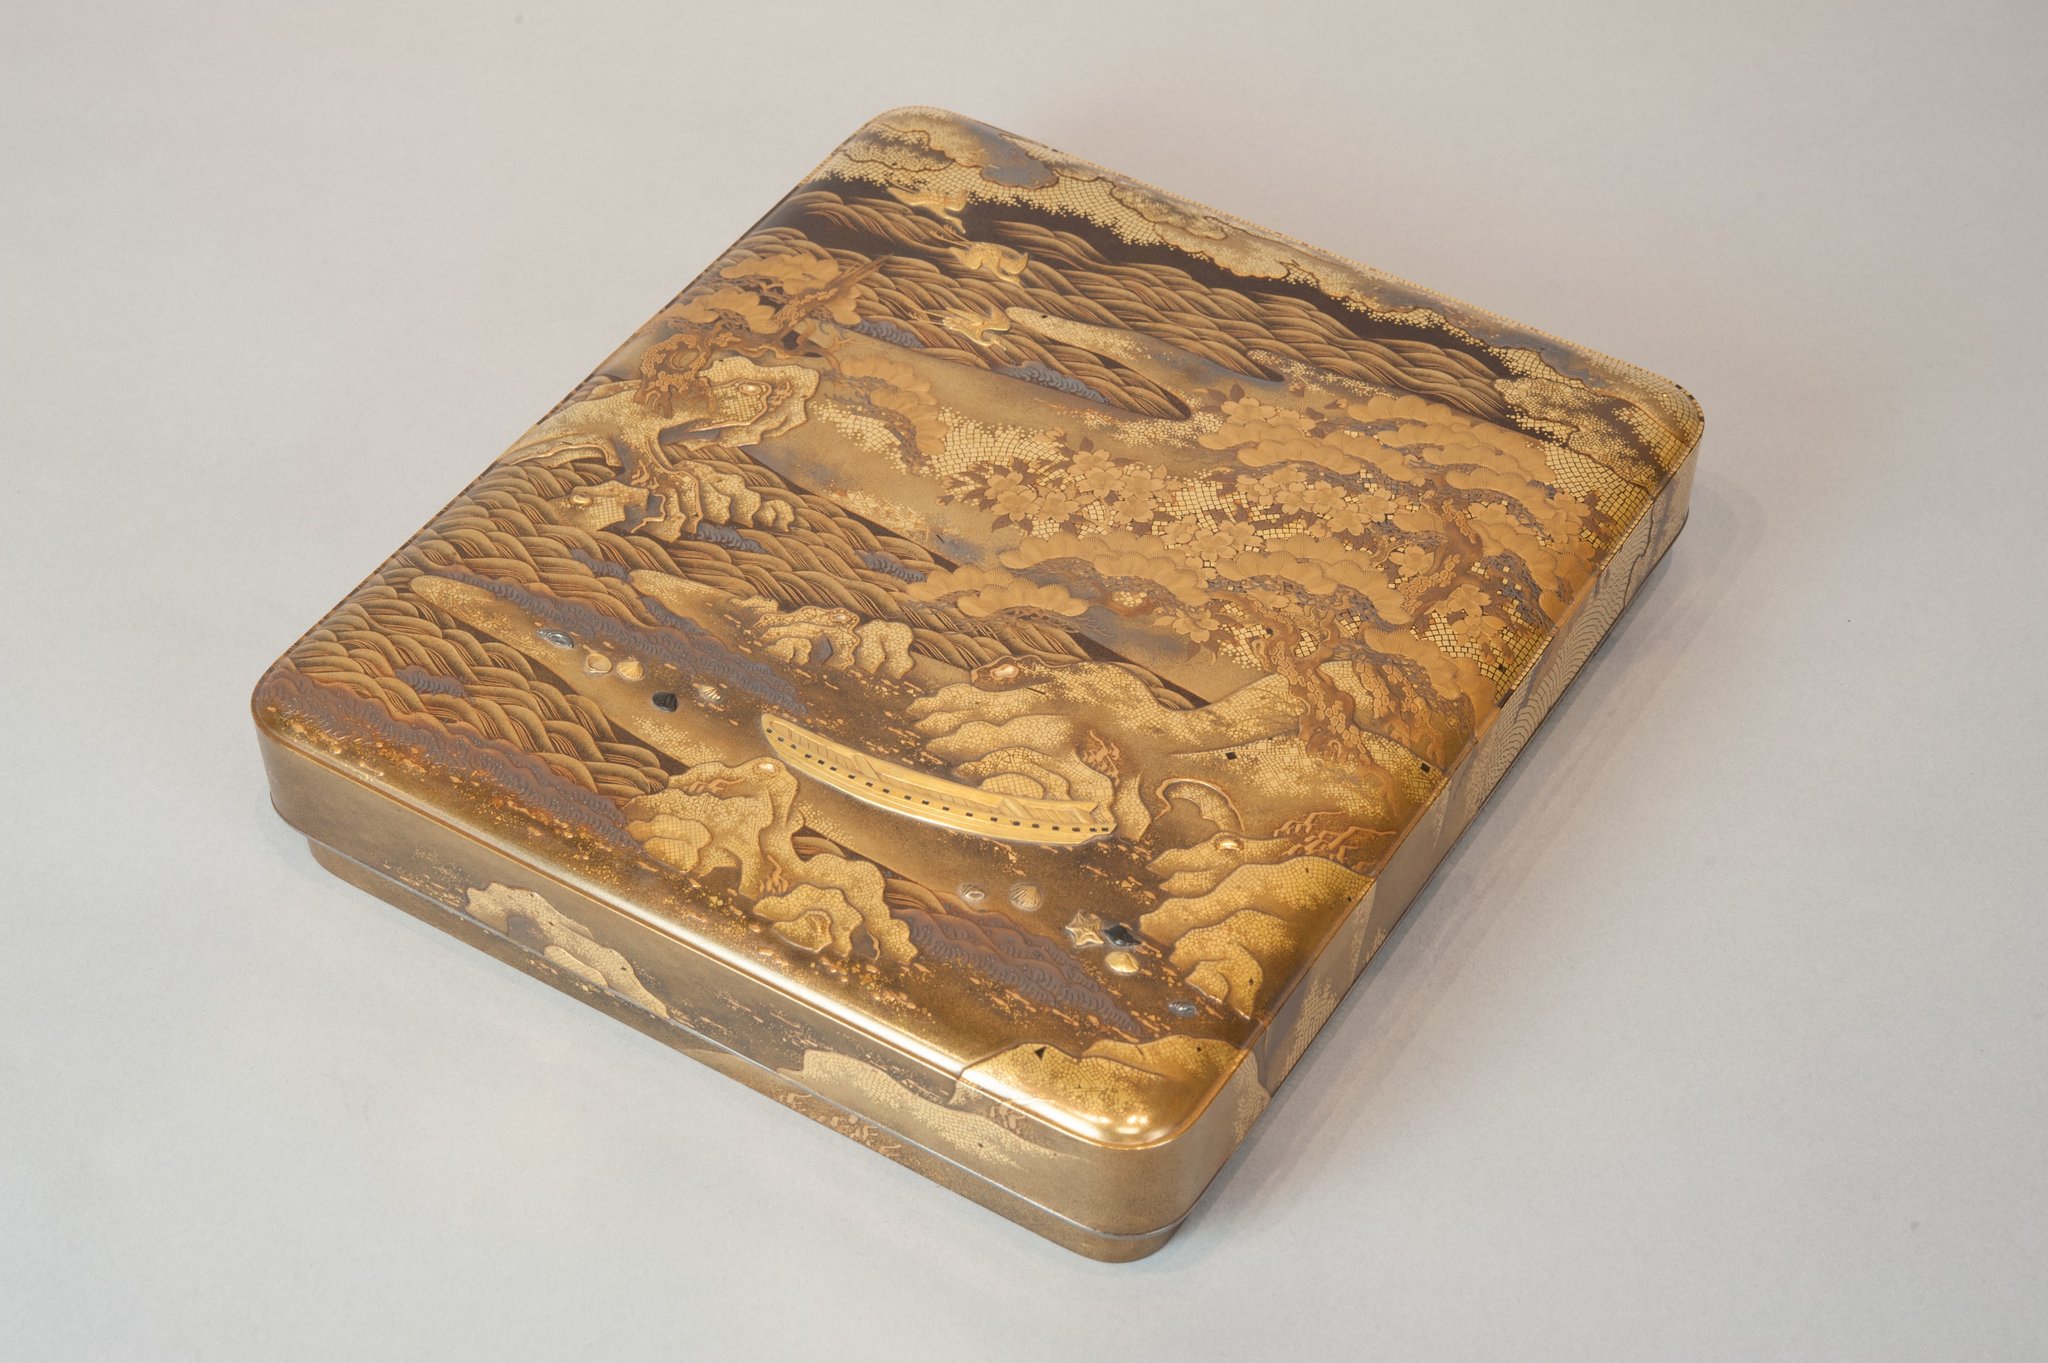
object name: writing box with writing utensil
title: Writing Box with a Scene from the “Butterflies” Chapter of The Tale of Genji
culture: japanese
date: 1901-2000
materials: gold, lacquer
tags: landscapes,boats